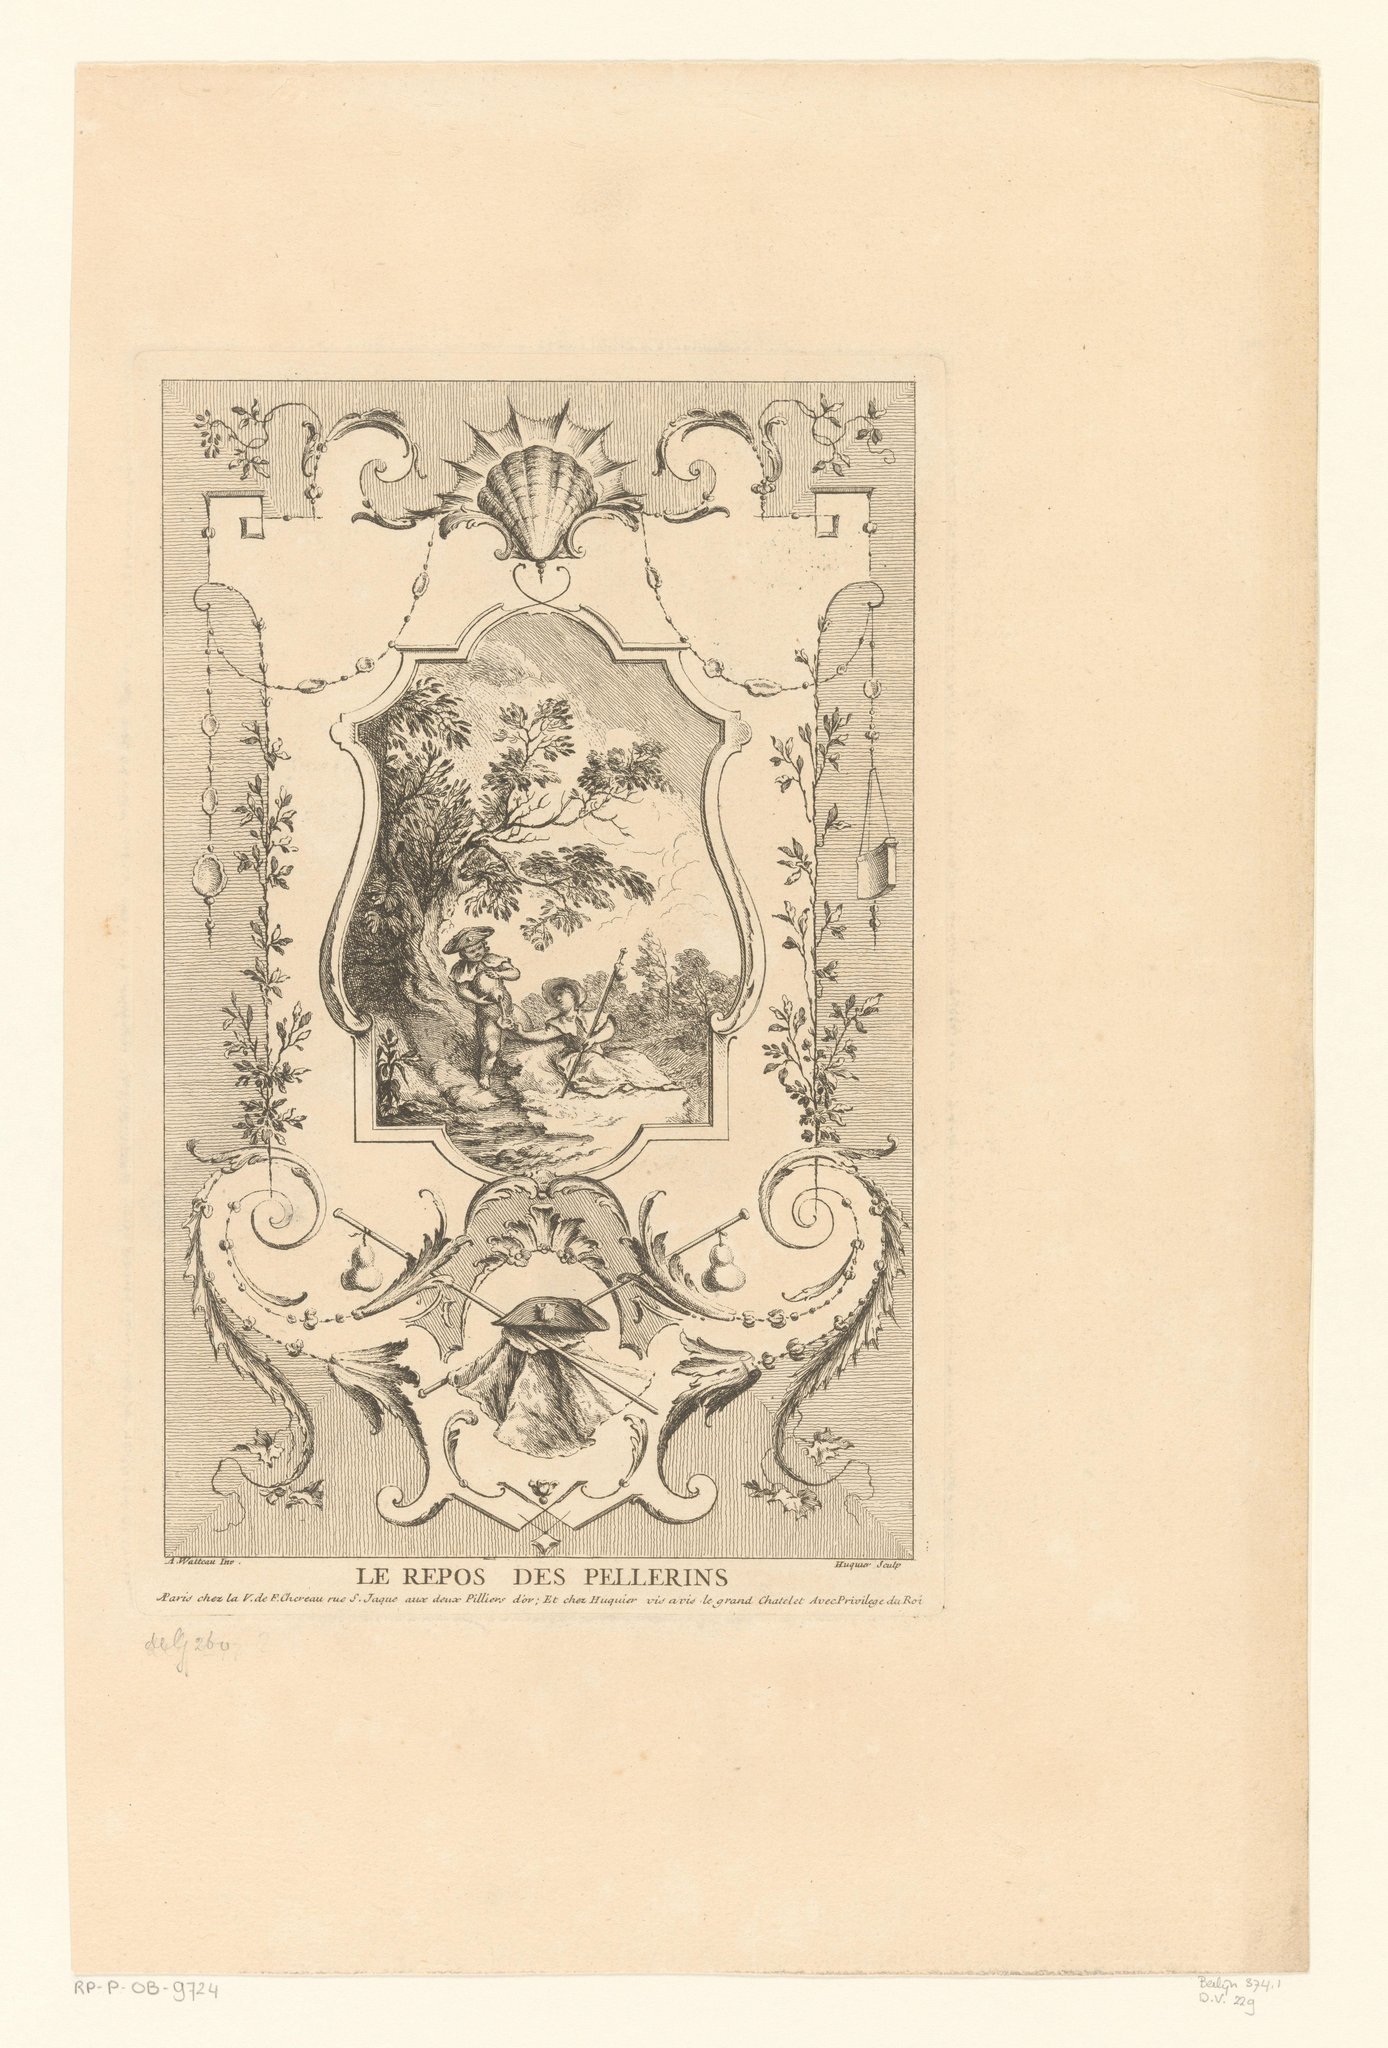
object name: ornament print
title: Rustende pelgrims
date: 1729-1737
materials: paper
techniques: etching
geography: paris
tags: pilgrimage, pilgrim(s) under way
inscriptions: collector's mark: Lugt 2228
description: In een landschap rusten en drinken twee pelgrims. Rondom een omlijsting met bladmotieven, schelpkettingen, rocailles en aan de onderzijde pelgrimsstaven, een cape en een hoed.